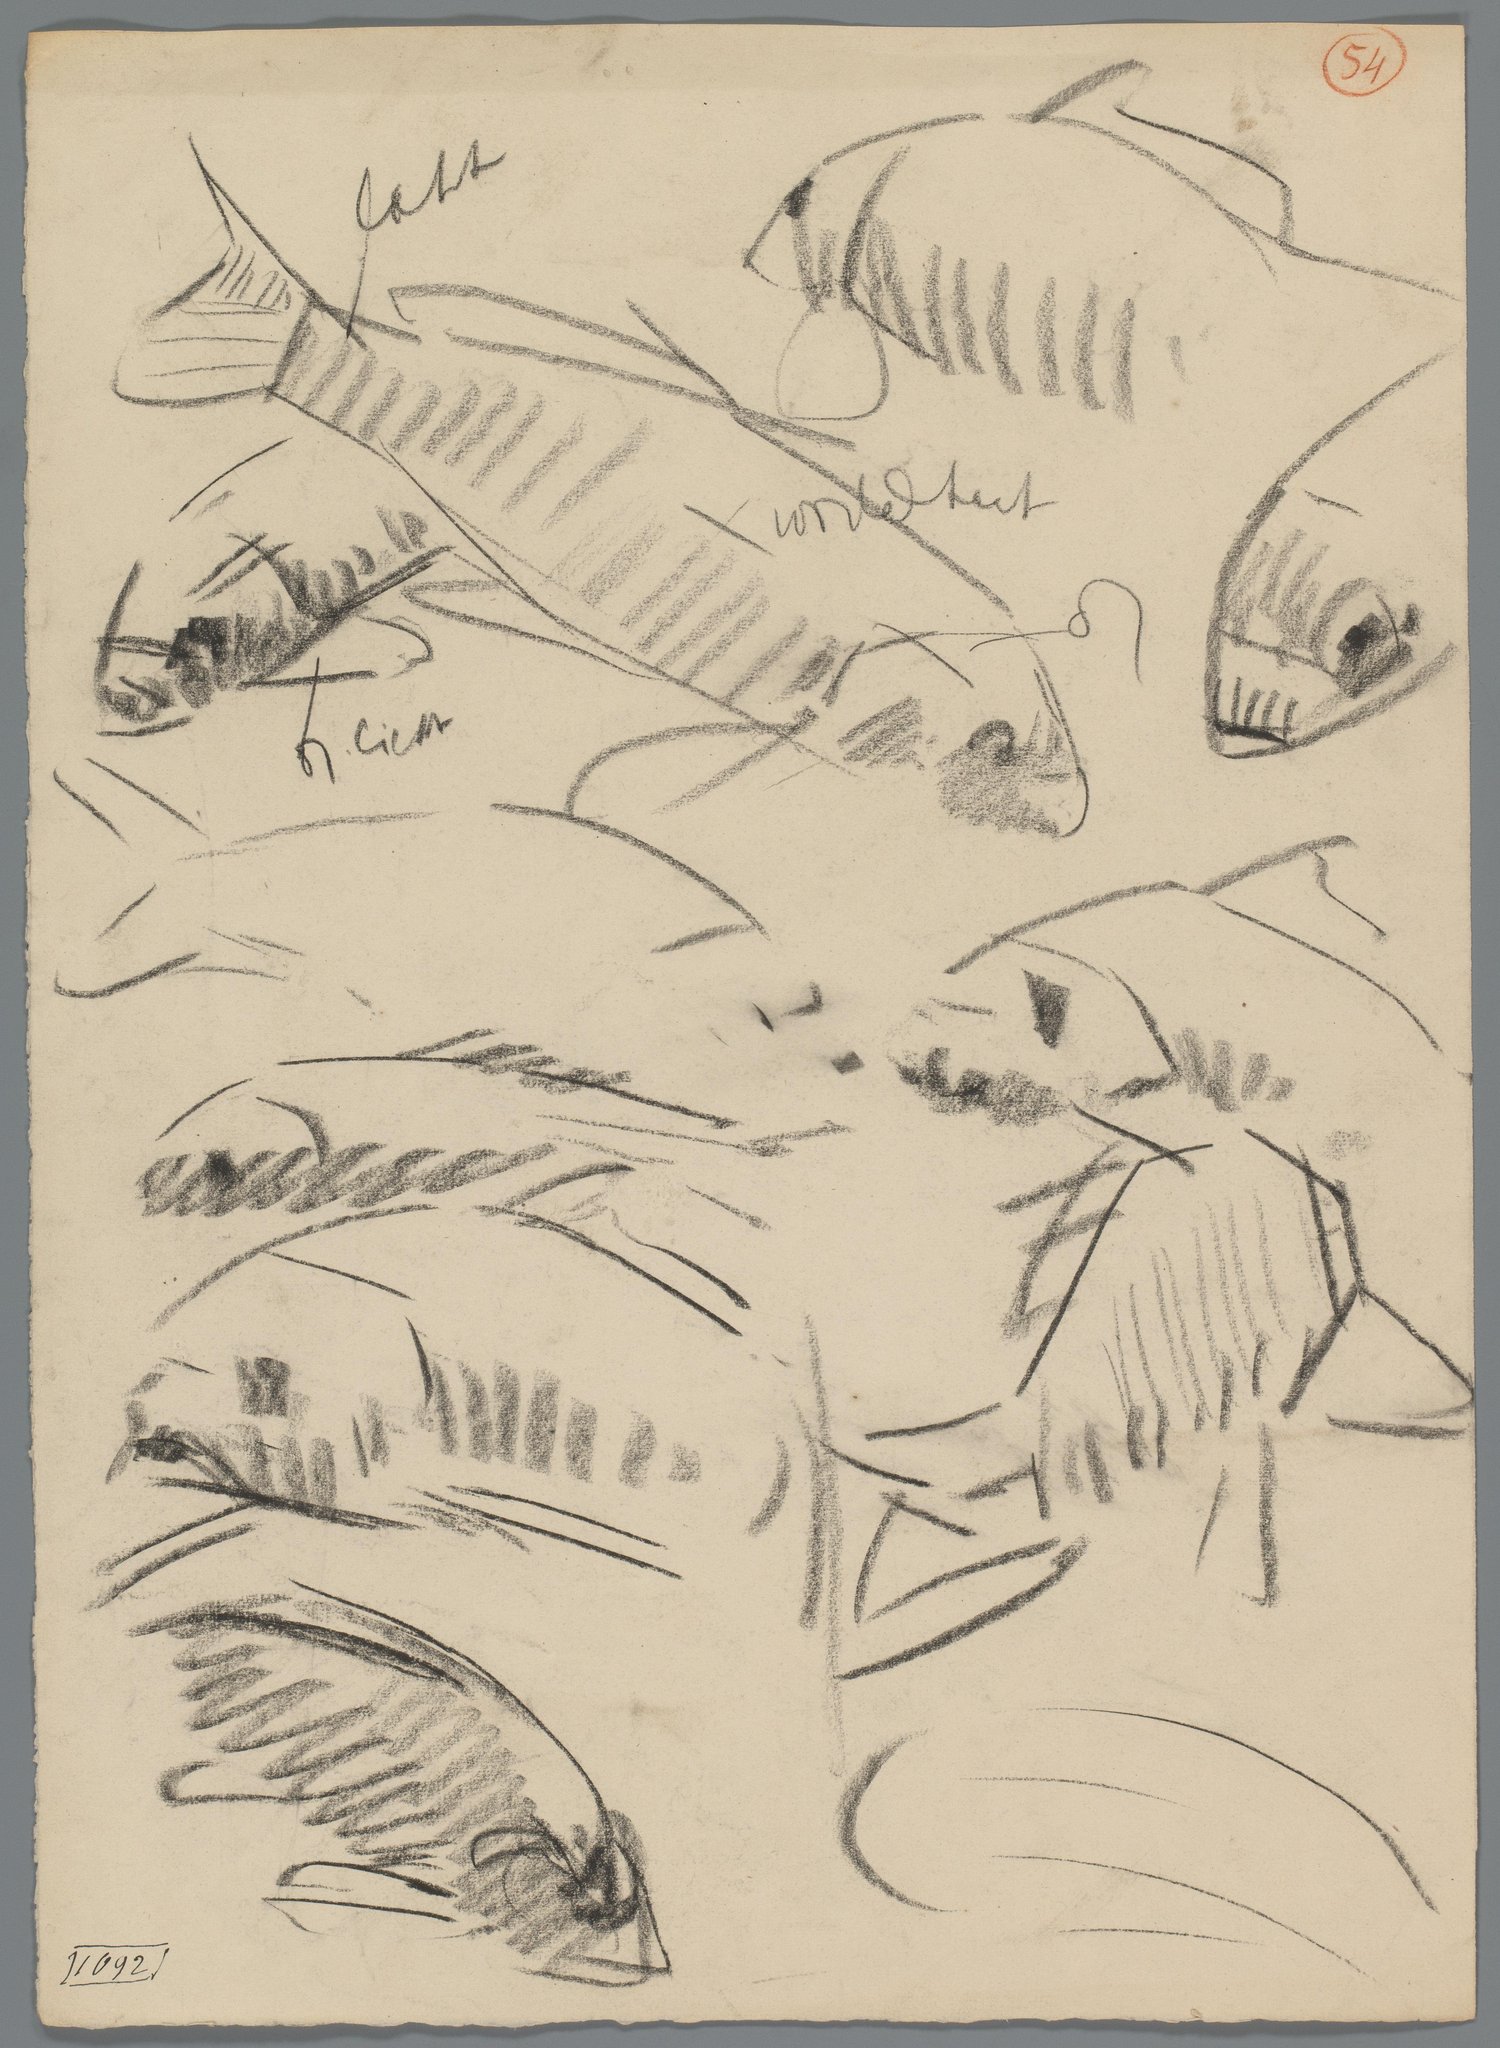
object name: drawing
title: Studies van karpers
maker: gerrit willem dijsselhof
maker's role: designer, draughtsman, print maker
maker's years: 1866-1924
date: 1876-1924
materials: chalk, paper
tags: bony fishes: carp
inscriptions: number: ‘1092’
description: Met aantekeningen. Rechtsboven genummerd: 54.